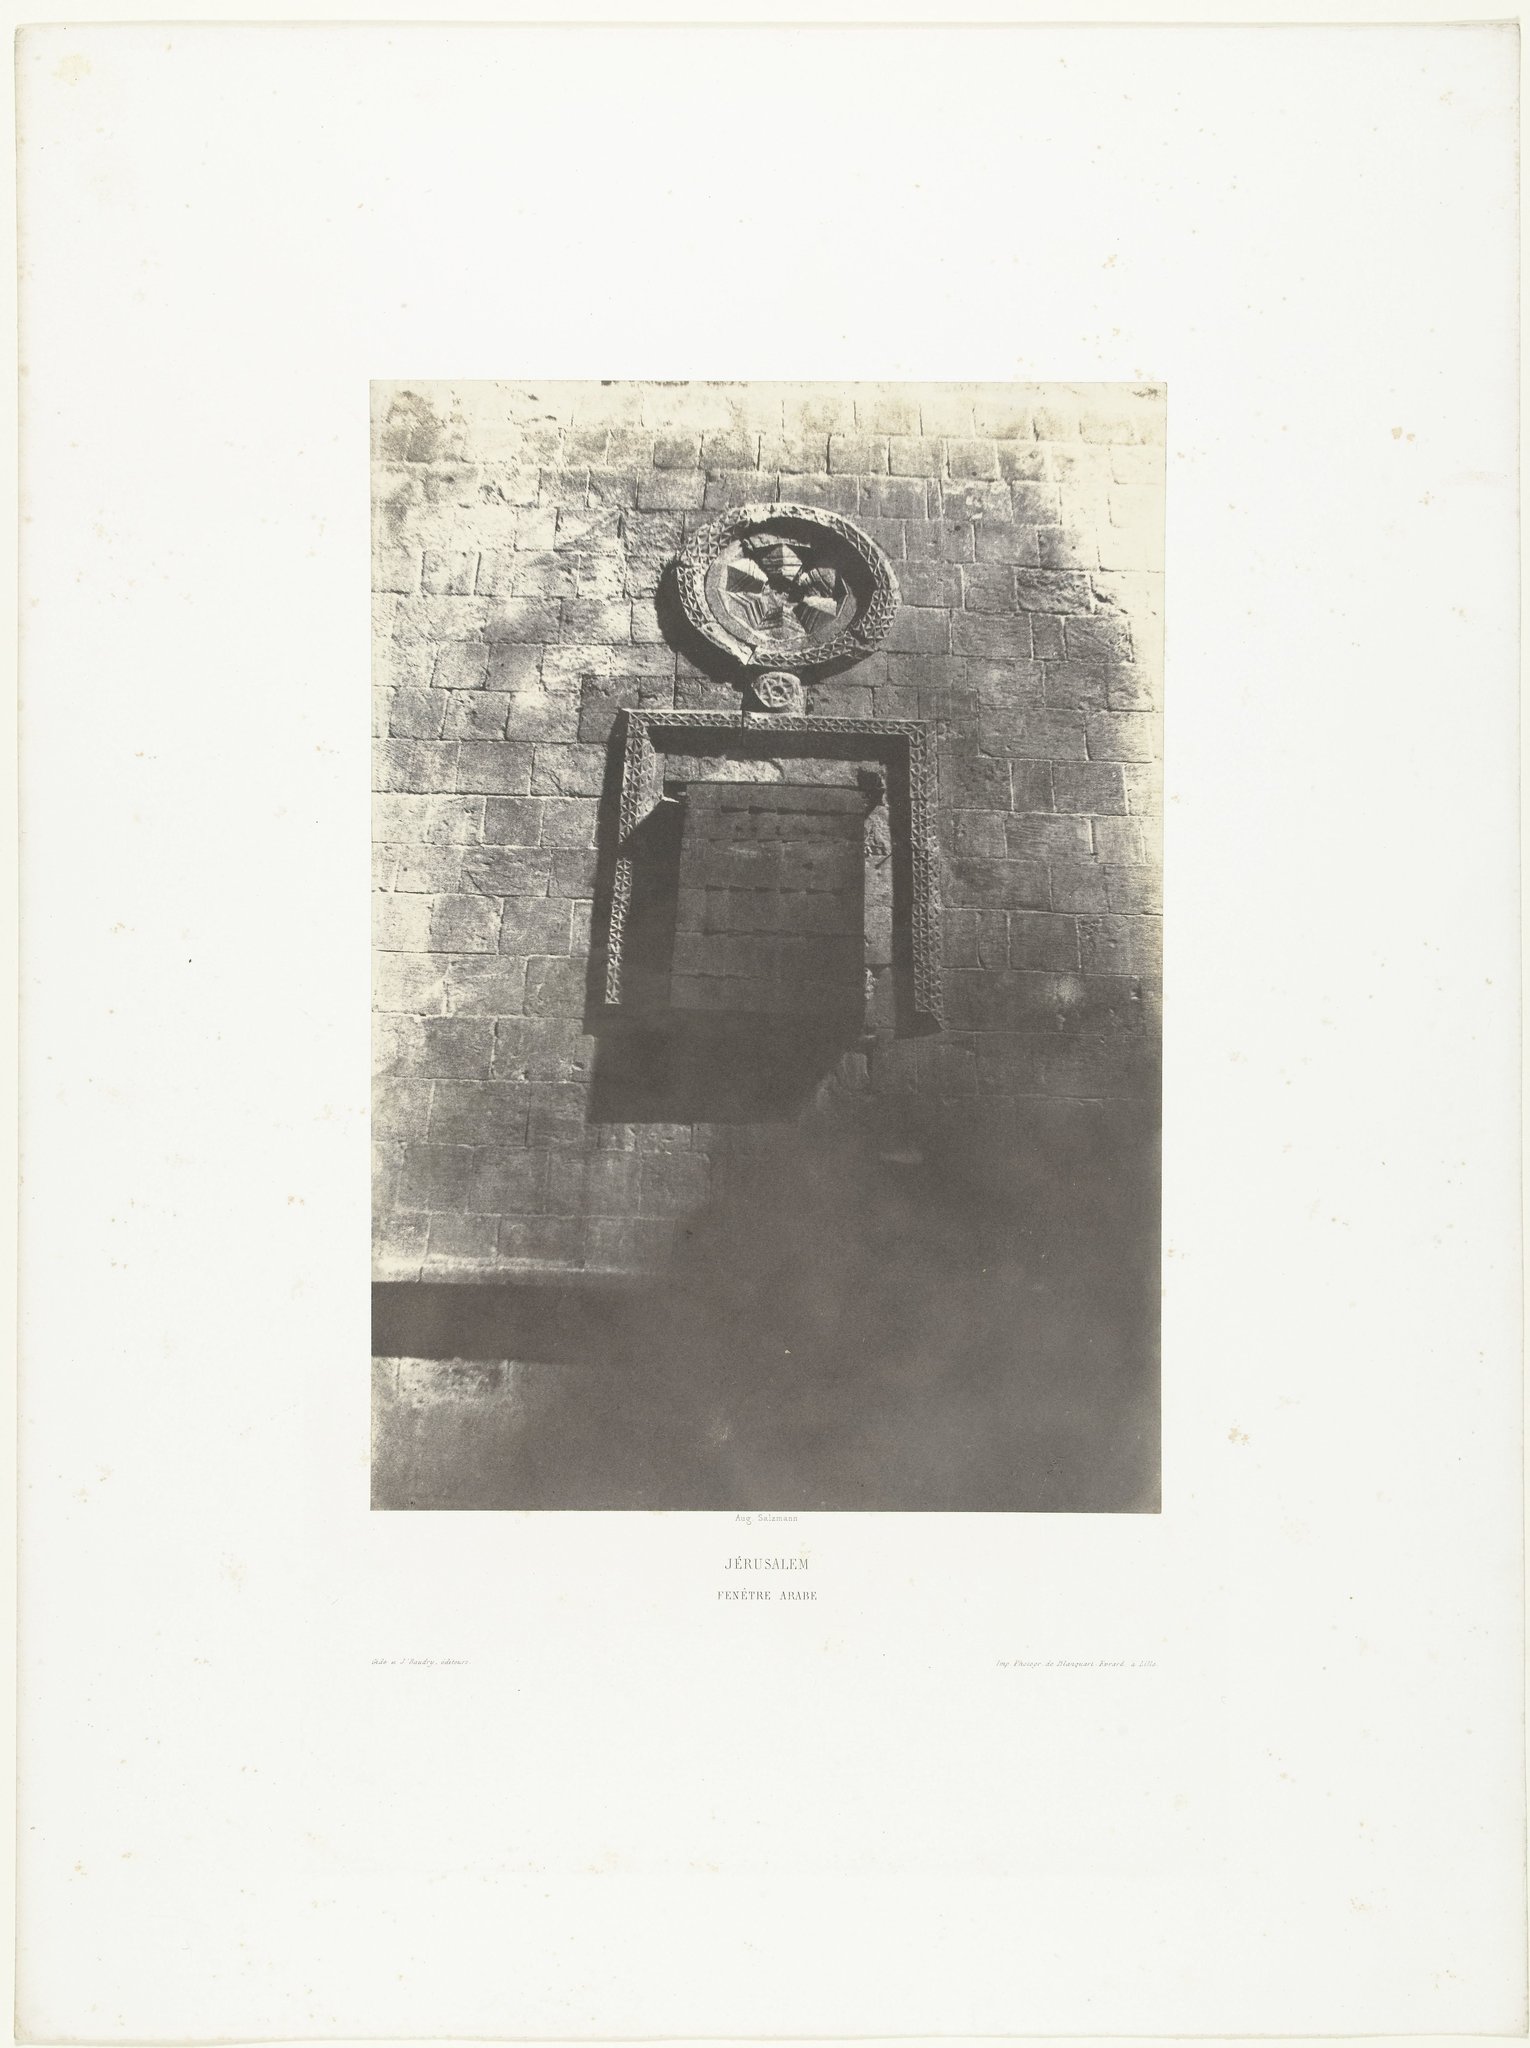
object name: photograph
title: Arabisch raam in Jeruzalem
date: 1856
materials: paper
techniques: salted paper print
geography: paris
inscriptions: signature: ‘Aug. Salzmann’, title: ‘JÉRUSALEM FENÊTRE ARABE’, annotation: ‘Imp. Photogr. de Blanquart-Evrard, à Lille.’, annotation: ‘Gide et J. Baudry, éditeurs.’